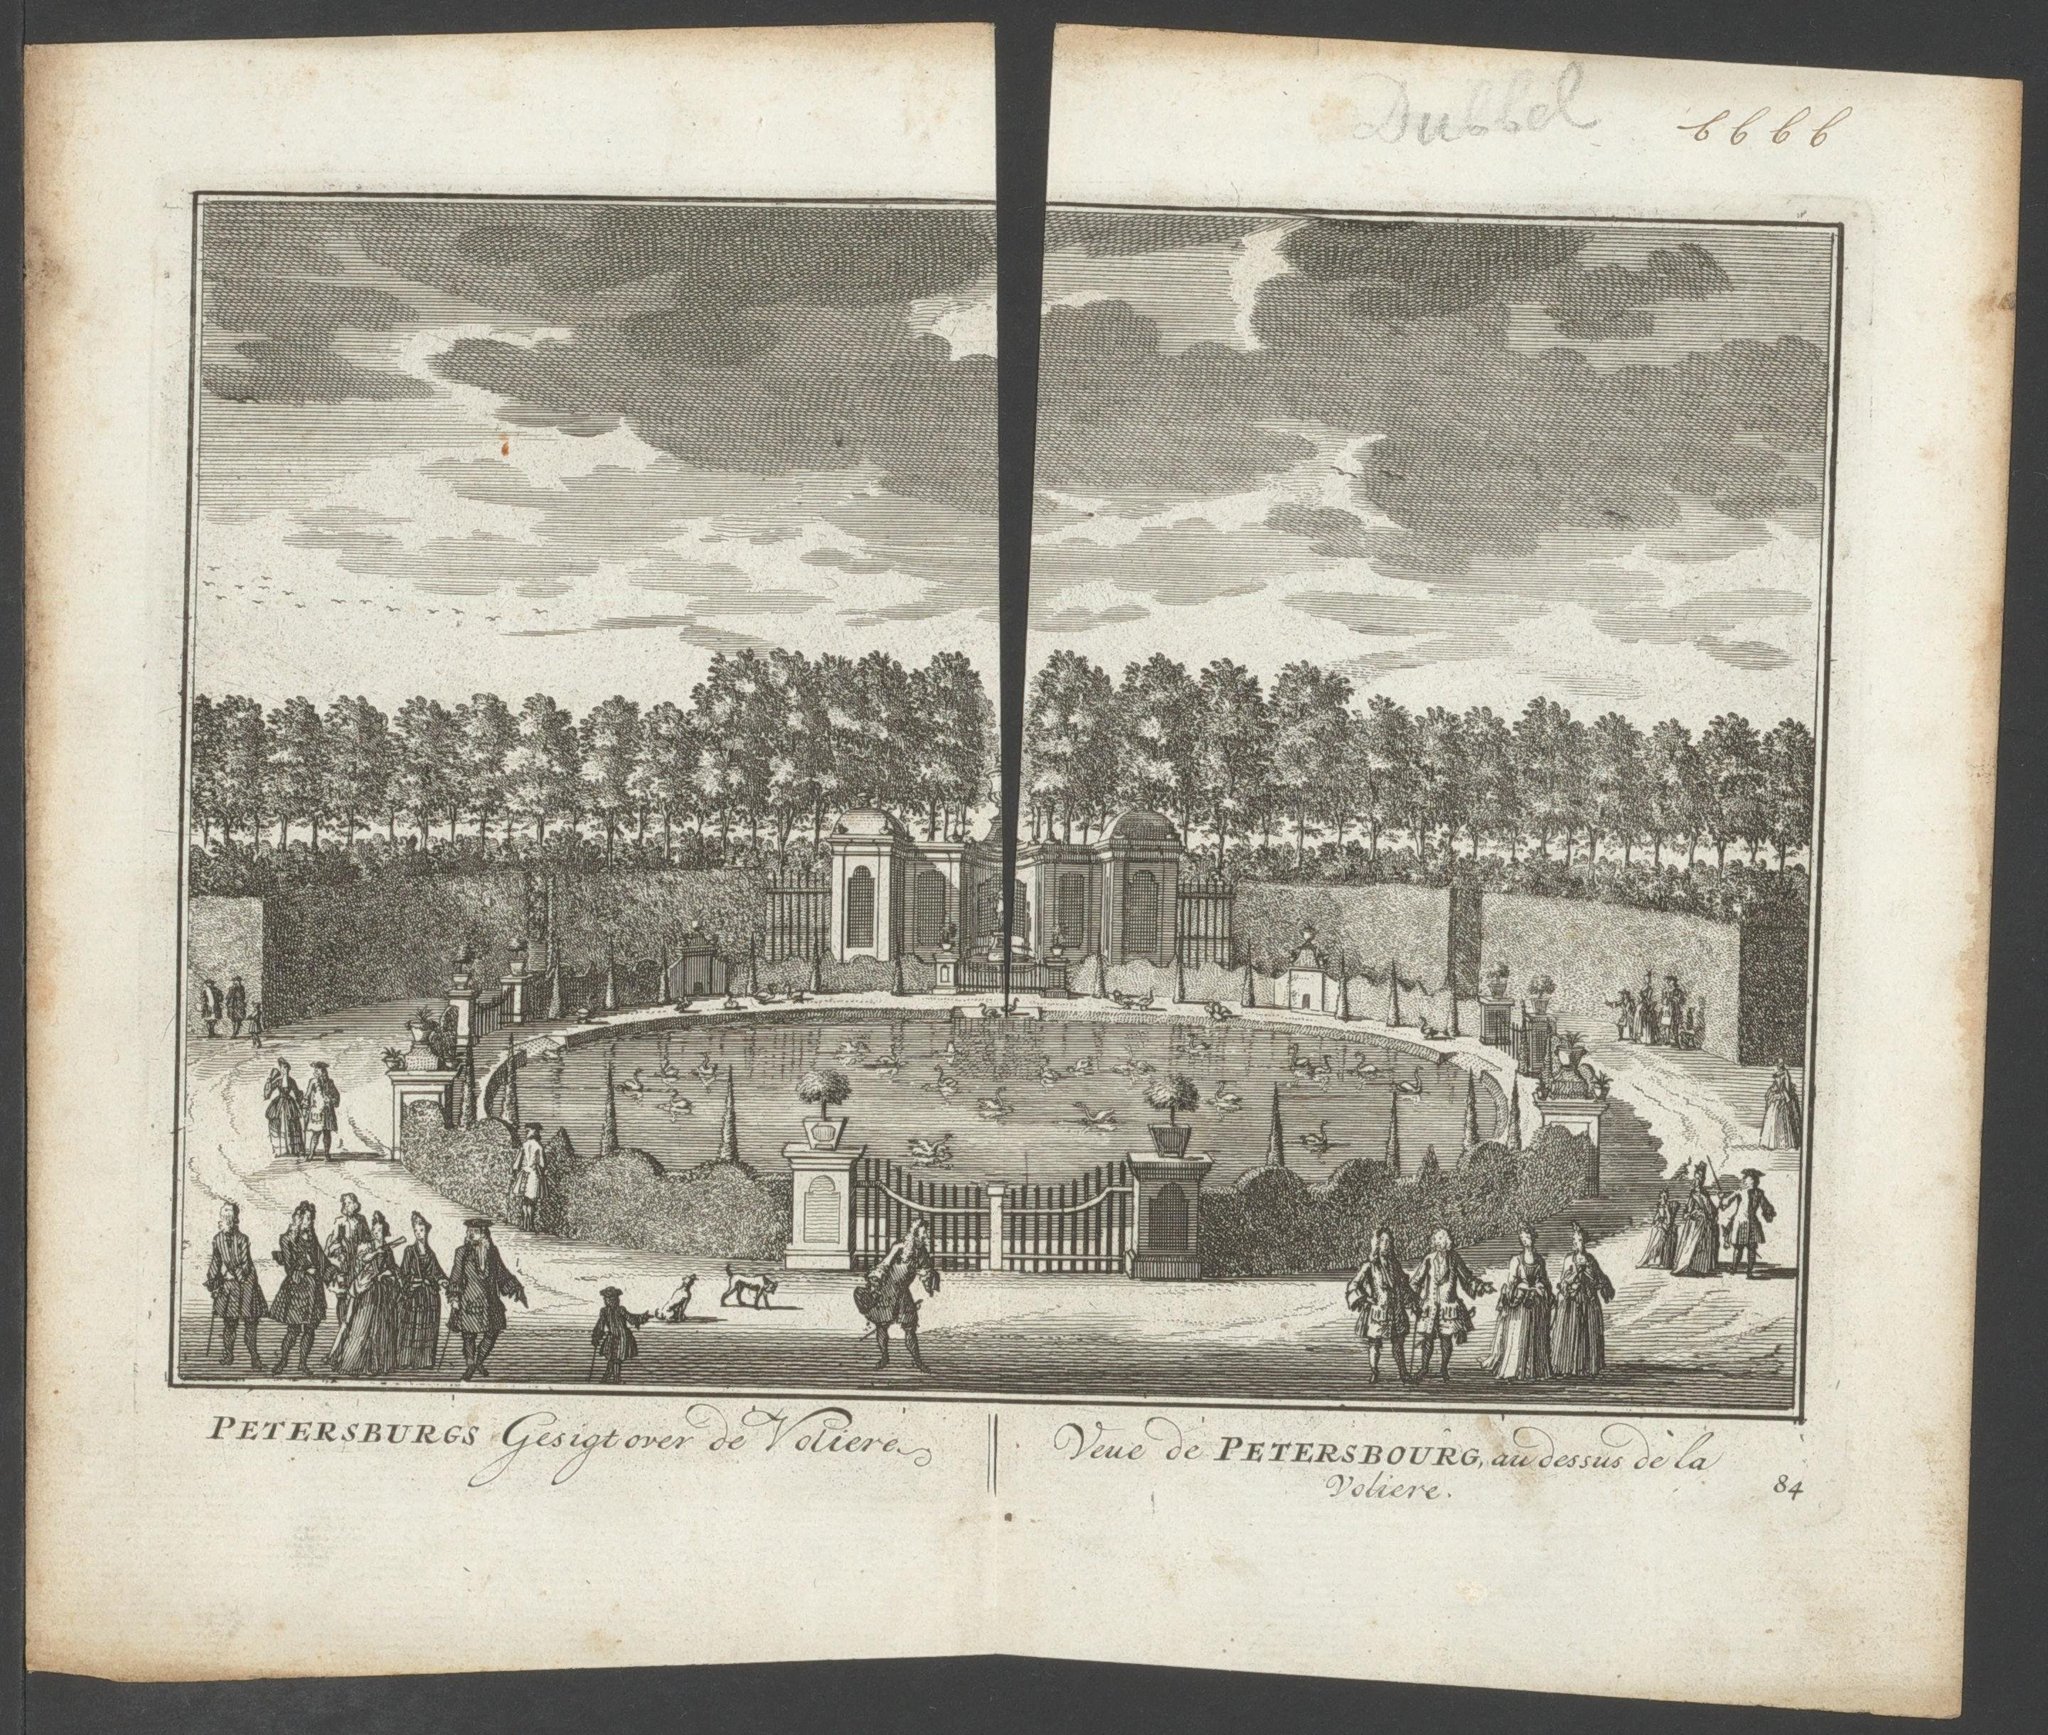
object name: print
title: Petersburgs Gesigt over de Voliere / Veue de Petersbourg, au dessus de la Voliere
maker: daniël stopendaal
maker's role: print maker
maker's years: 1672-1726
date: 1719-1790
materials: paper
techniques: engraving, etching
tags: birds in a large cage, aviary, french or architectonic garden; formal garden, country-house, nederhorst den berg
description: Prent voor het eerst gebruikt in: Leth, Andries de. De zegepraalende Vecht, vertoonende verscheidene gesichten van lustplaatsen, heeren huysen en dorpen, beginnende van Uitrecht en met Muyden besluytende (...). Amsterdam: Weduwe Nicolaus Visscher, 1719. Prent mogelijk uit: Brouërius van Nidek, Matthaeus. De Vechtstroom, van Utrecht tot Muiden (...). Amsterdam: H. Gartman, W. Vermandel en J.W. Smit, 1790.